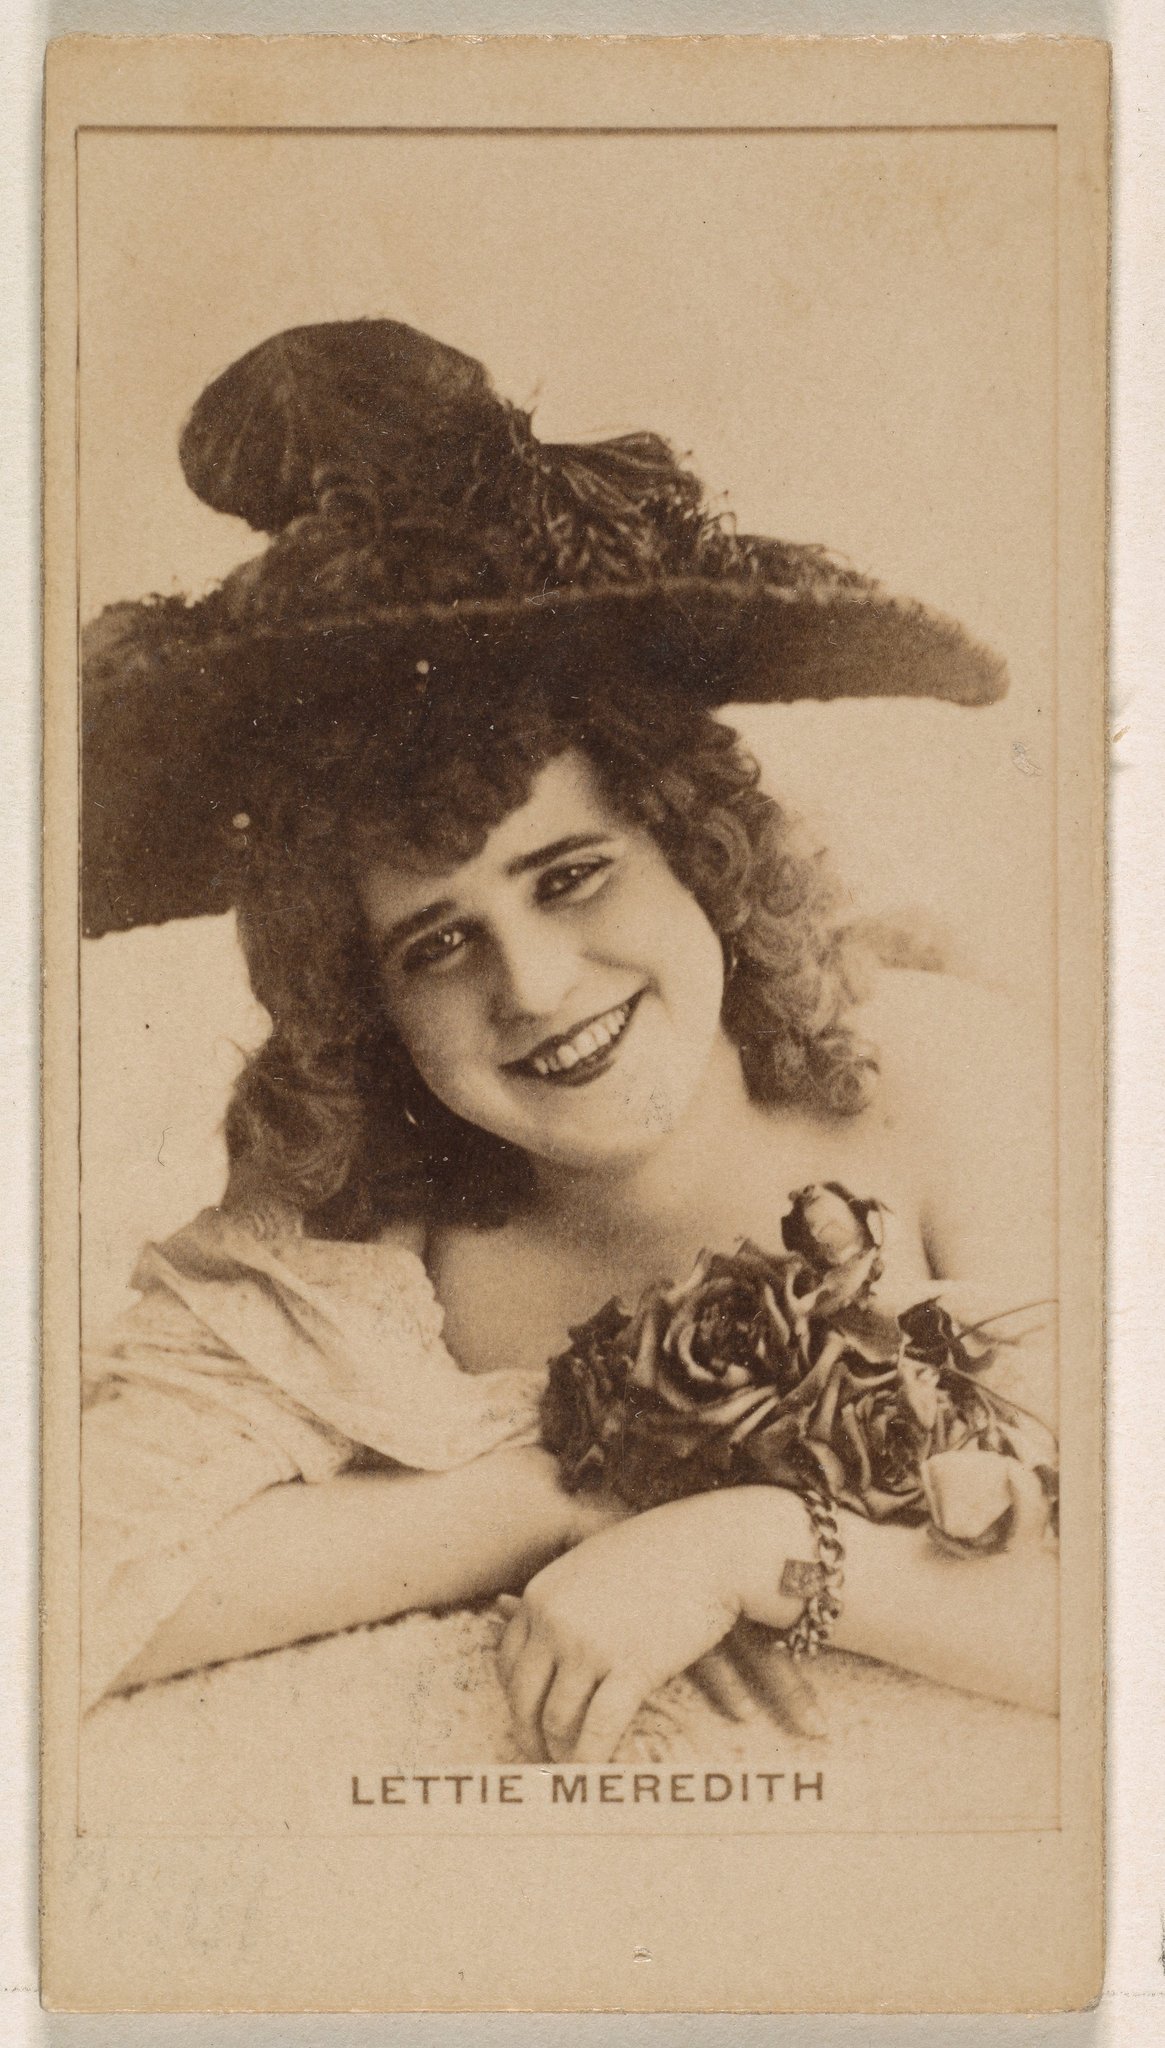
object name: photograph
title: Lettie Meredith, from the Actresses series (N245) issued by Kinney Brothers to promote Sweet Caporal Cigarettes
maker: kinney brothers tobacco company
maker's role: publisher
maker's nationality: american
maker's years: 1869-2011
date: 1890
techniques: albumen silver print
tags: portraits,women,actresses